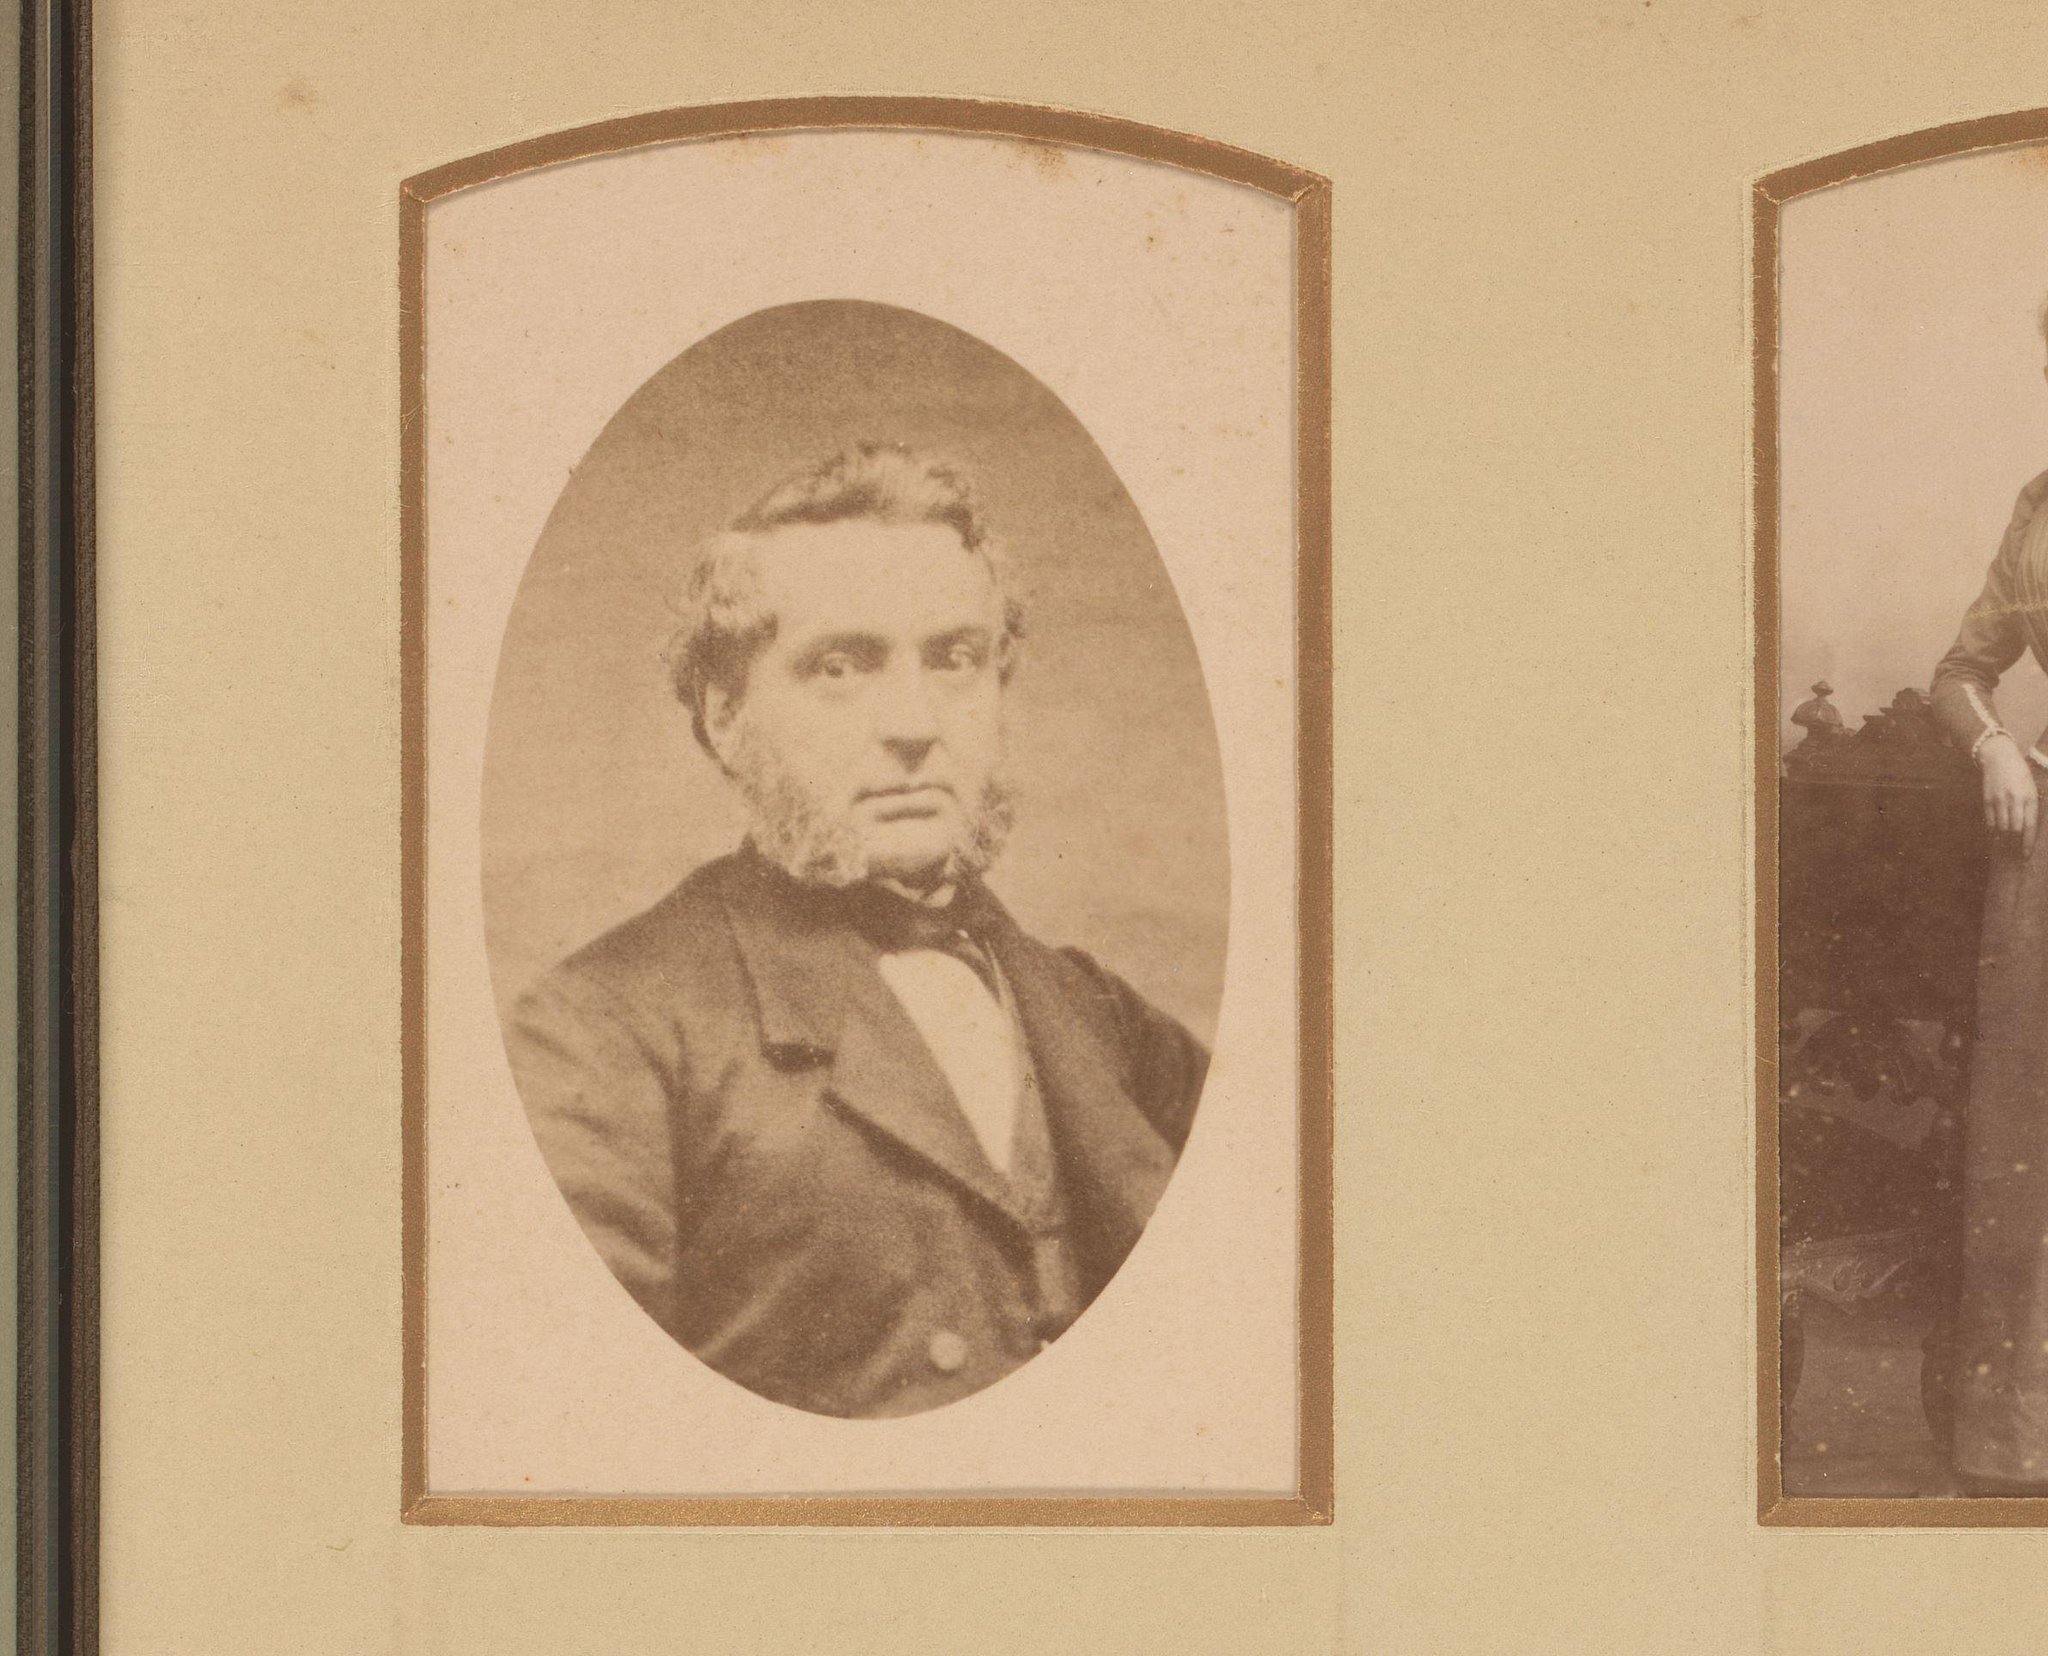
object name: photograph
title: Portret van een man met bakkebaarden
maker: cornelis johannes lodewicus vermeulen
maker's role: fotograaf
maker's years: 1861-1936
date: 1888-1896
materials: cardboard, photographic support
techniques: albumen print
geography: amsterdam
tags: sideburns, historical persons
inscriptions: inscription: ‘Atelier/ Vermeulen/ Speciaal ingericht voor/ groepen en levensgroote portretten/ in onveranderlijke kooldruk/ Heerenstraat 6,/ Amsterdam.’